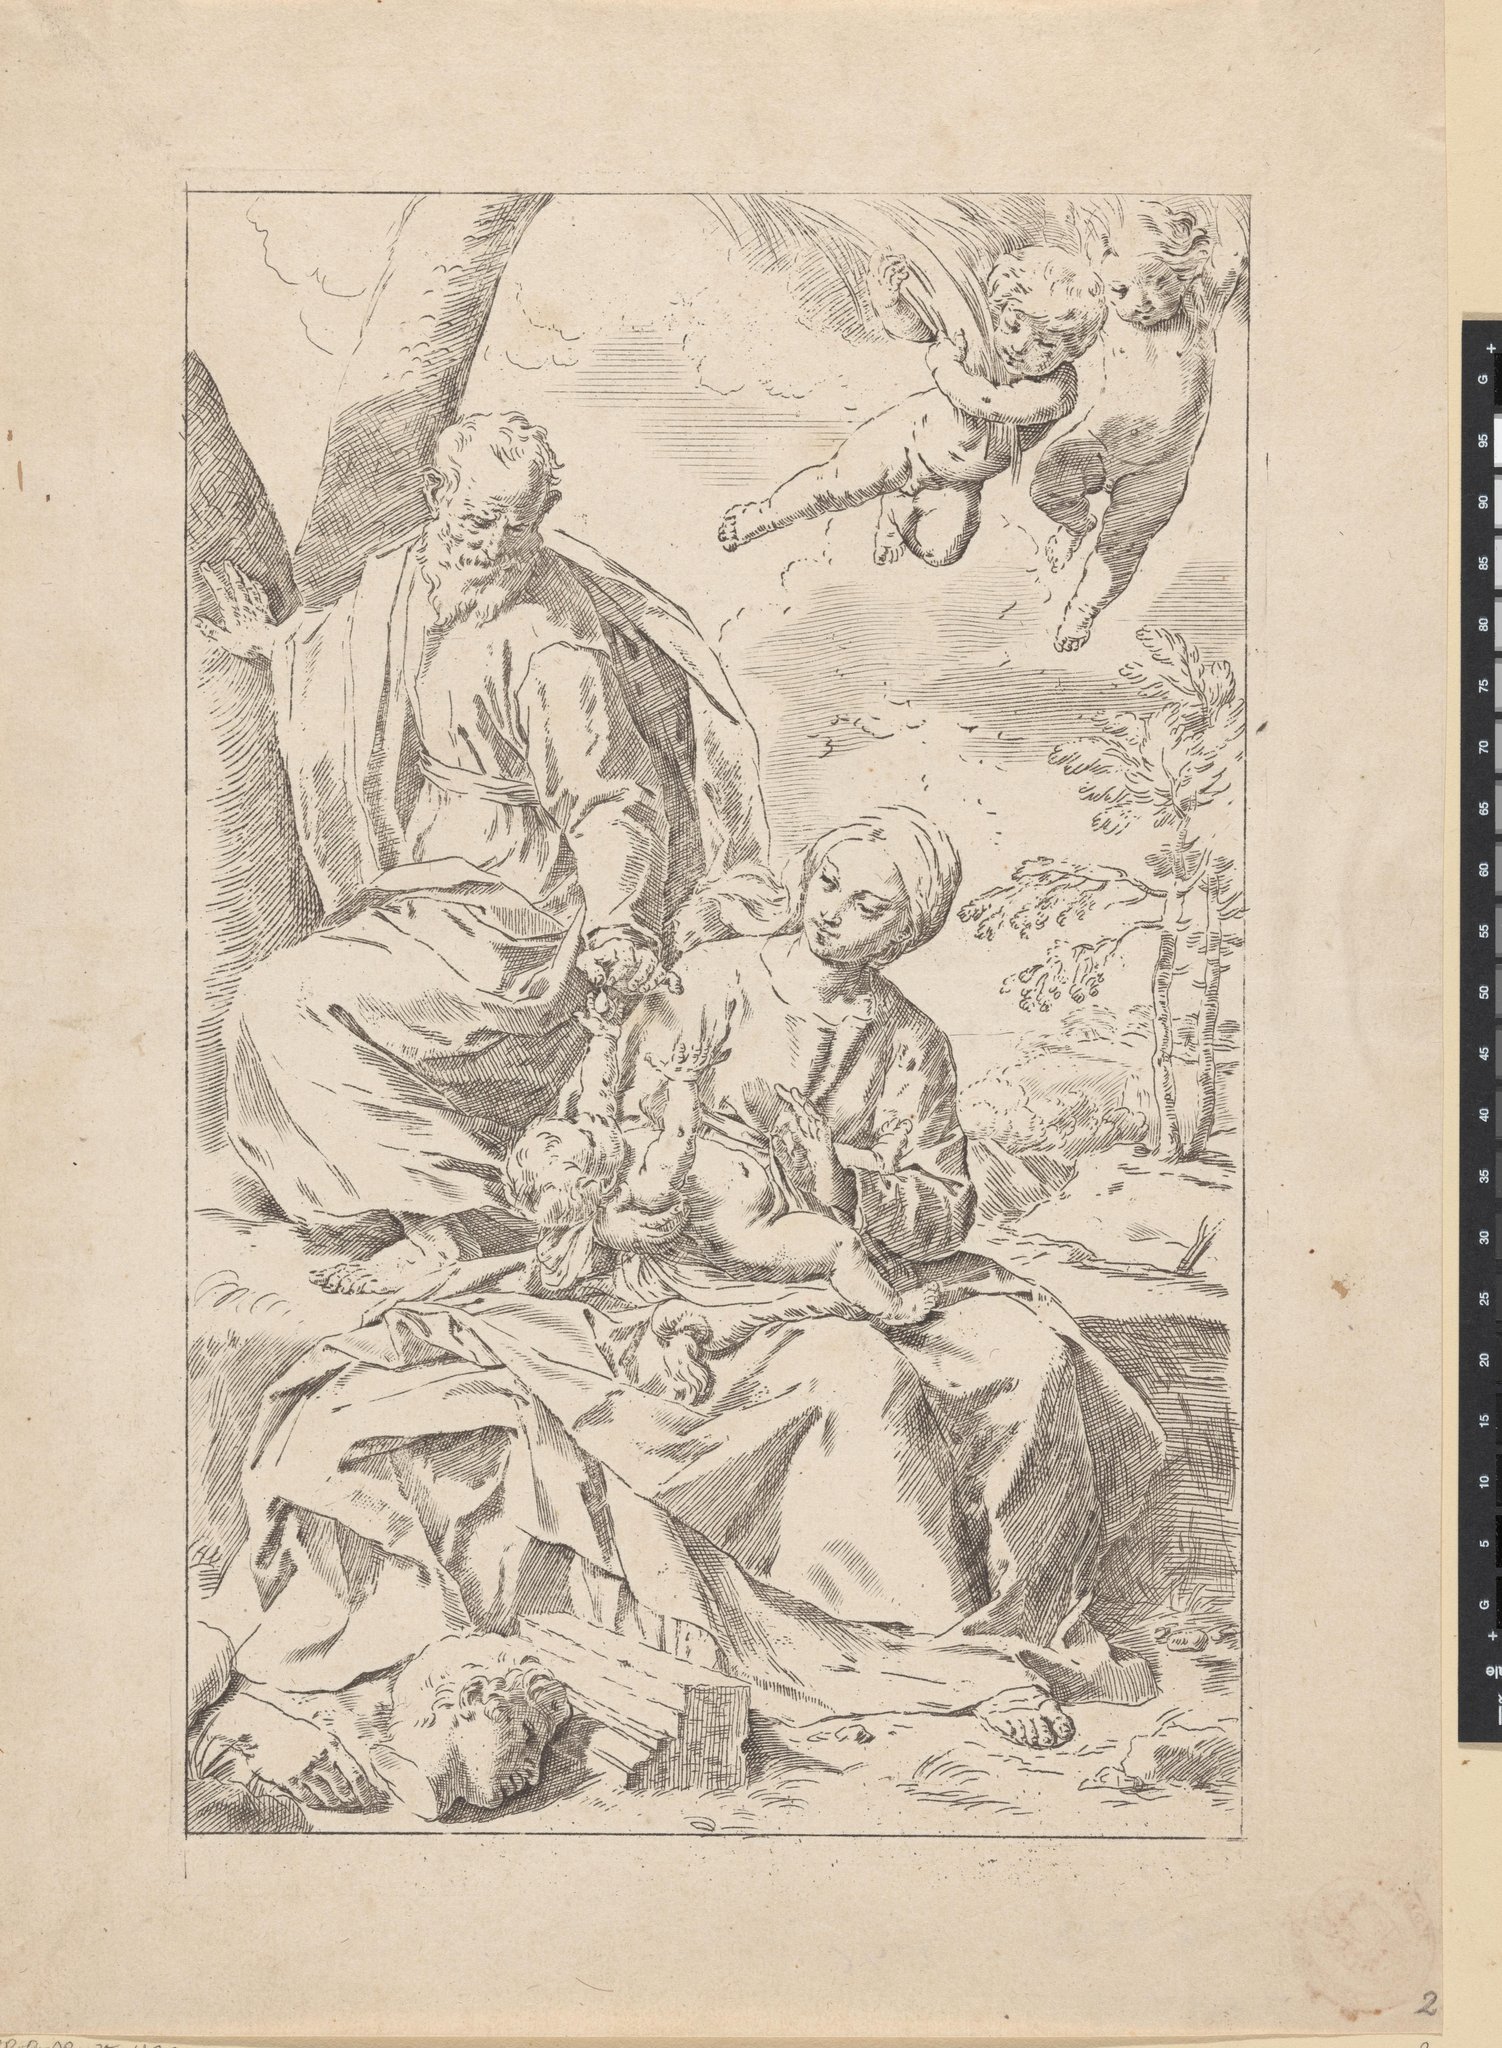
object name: print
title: Rust op de vlucht naar Egypte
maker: simone cantarini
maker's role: draughtsman, print maker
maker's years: 1612-1648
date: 1622-1648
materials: paper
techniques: etching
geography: italy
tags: rest on the flight into egypt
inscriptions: collector's mark: Lugt 240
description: De Heilige Familie rust onder een boom tijdens de vlucht naar Egypte. Jozef geeft een kleine vrucht aan het Christuskind dat bij Maria op schoot ligt. Rechtsboven twee putti.